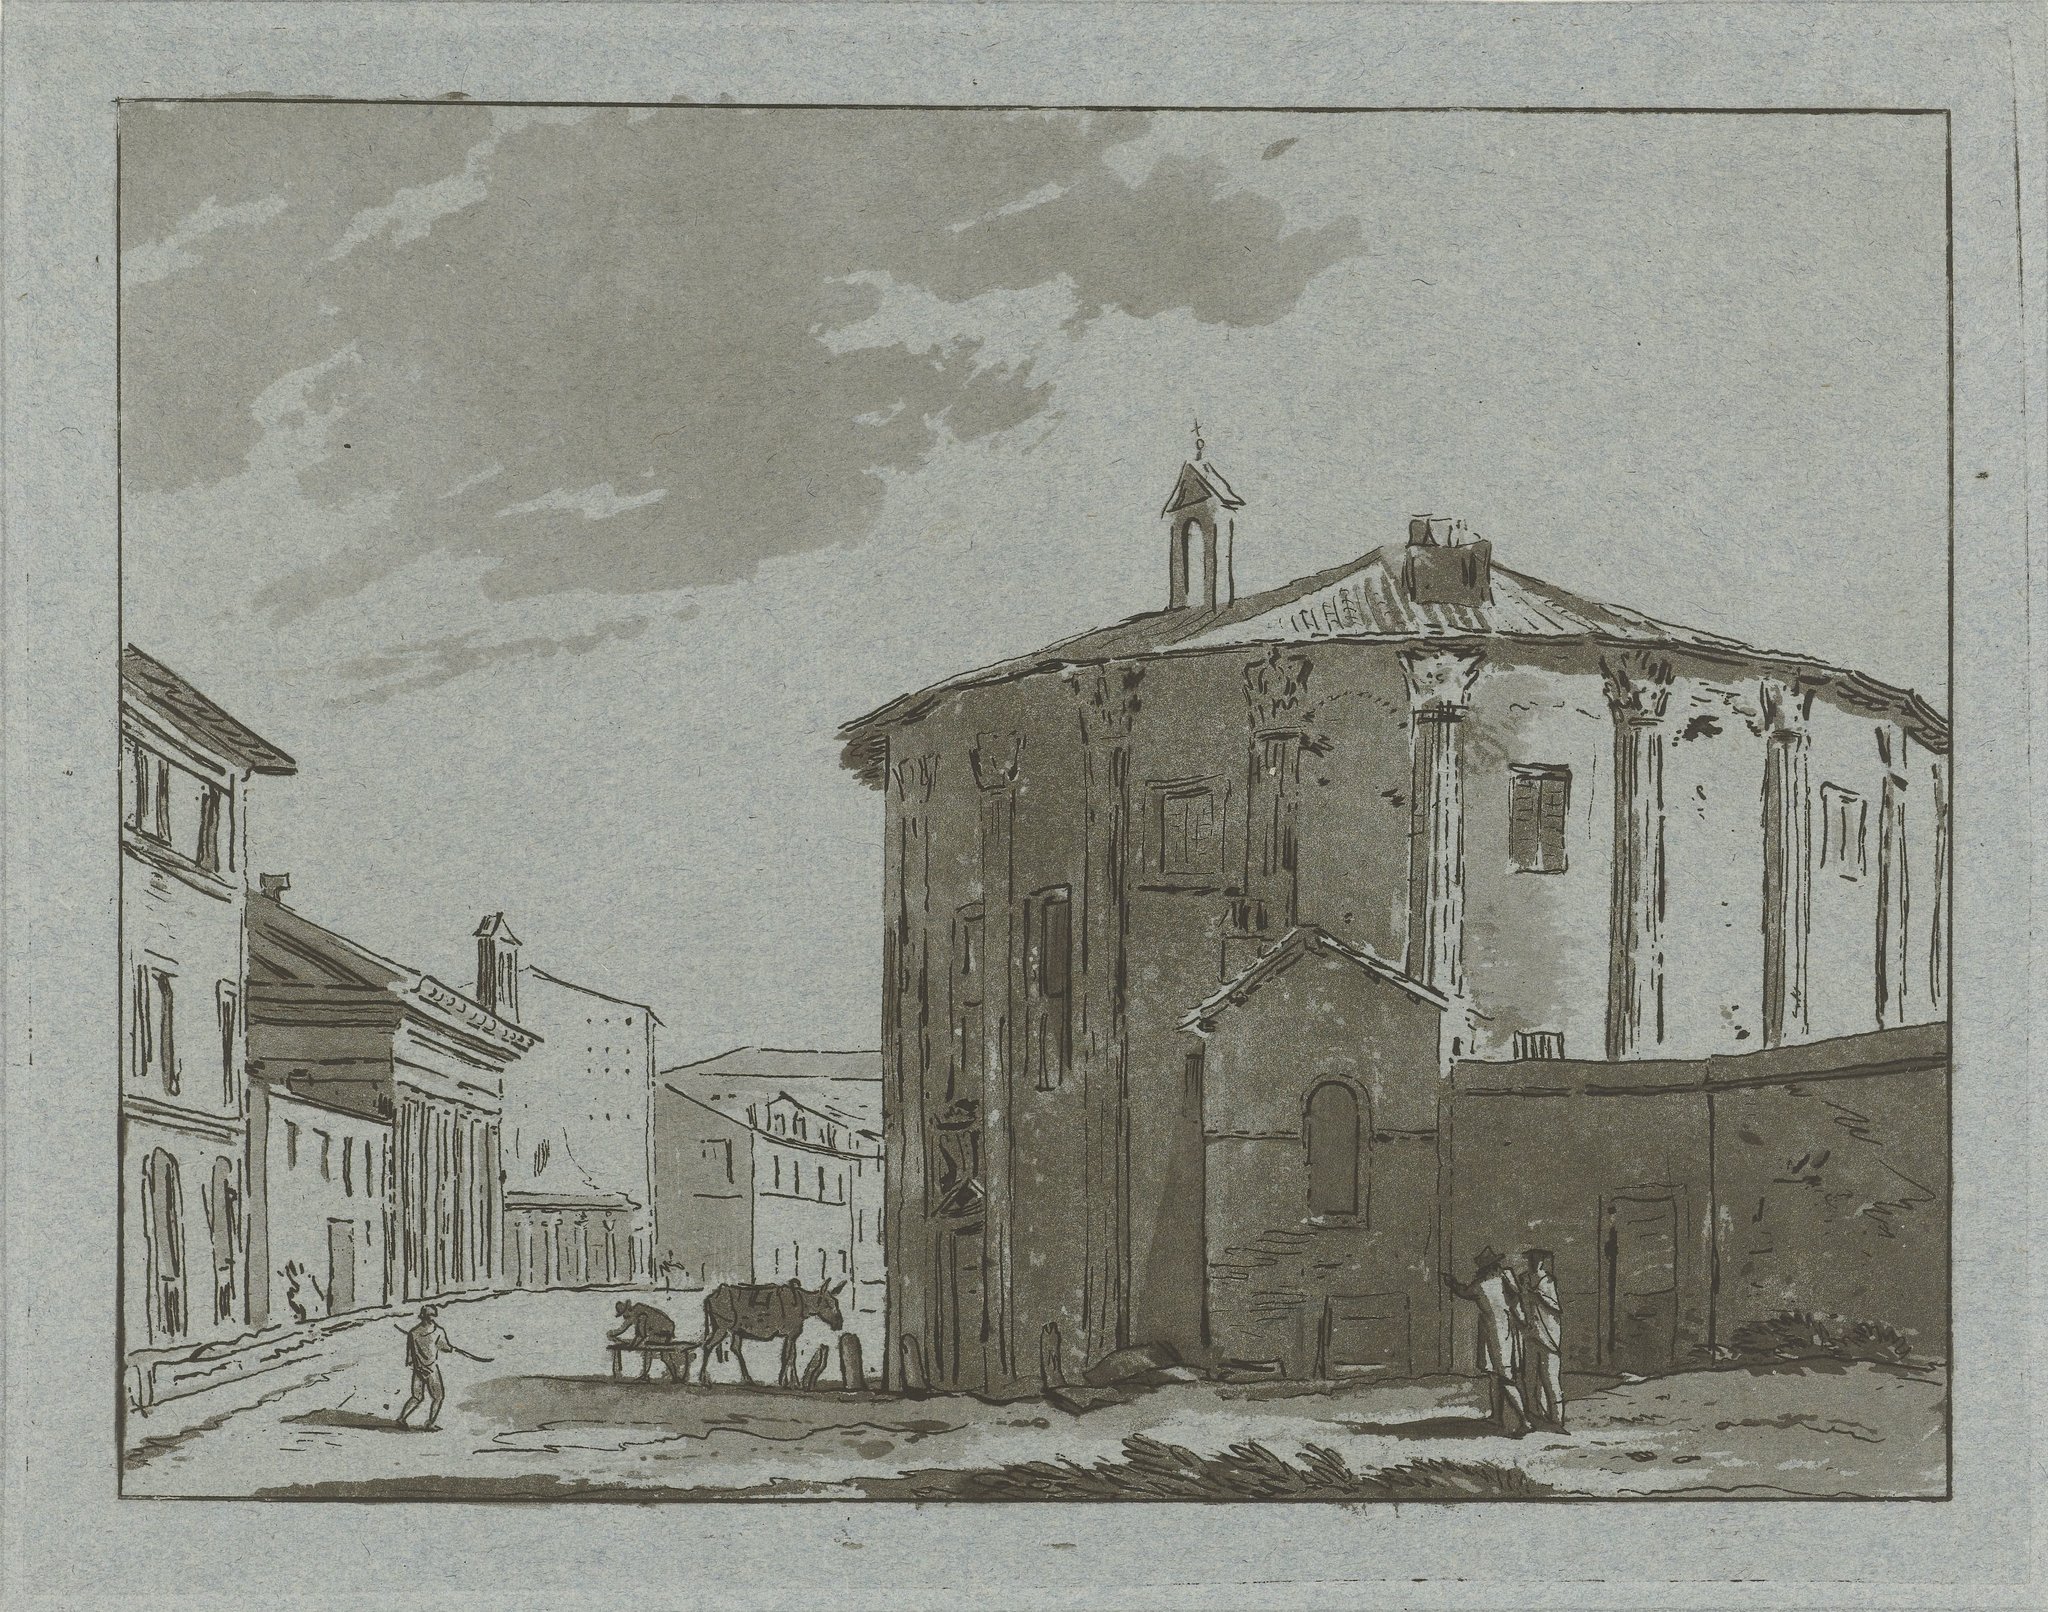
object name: print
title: Tempel te Rome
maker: hermanus fock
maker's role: conservator, draughtsman, painter, print maker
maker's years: 1766-1822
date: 1781-1810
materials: paper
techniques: aquatint, etching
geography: amsterdam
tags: temple, shrine ~ roman religion, city-view in general; 'veduta' - ii - ideal city (+ city(-scape) with figures, staffage)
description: Een stadsgezicht met een kerk in de voormalige Romeinse tempel van Hercules Invictus. Op straat lopen drie personen, een vierde persoon is aan het werk naast een muilezel.